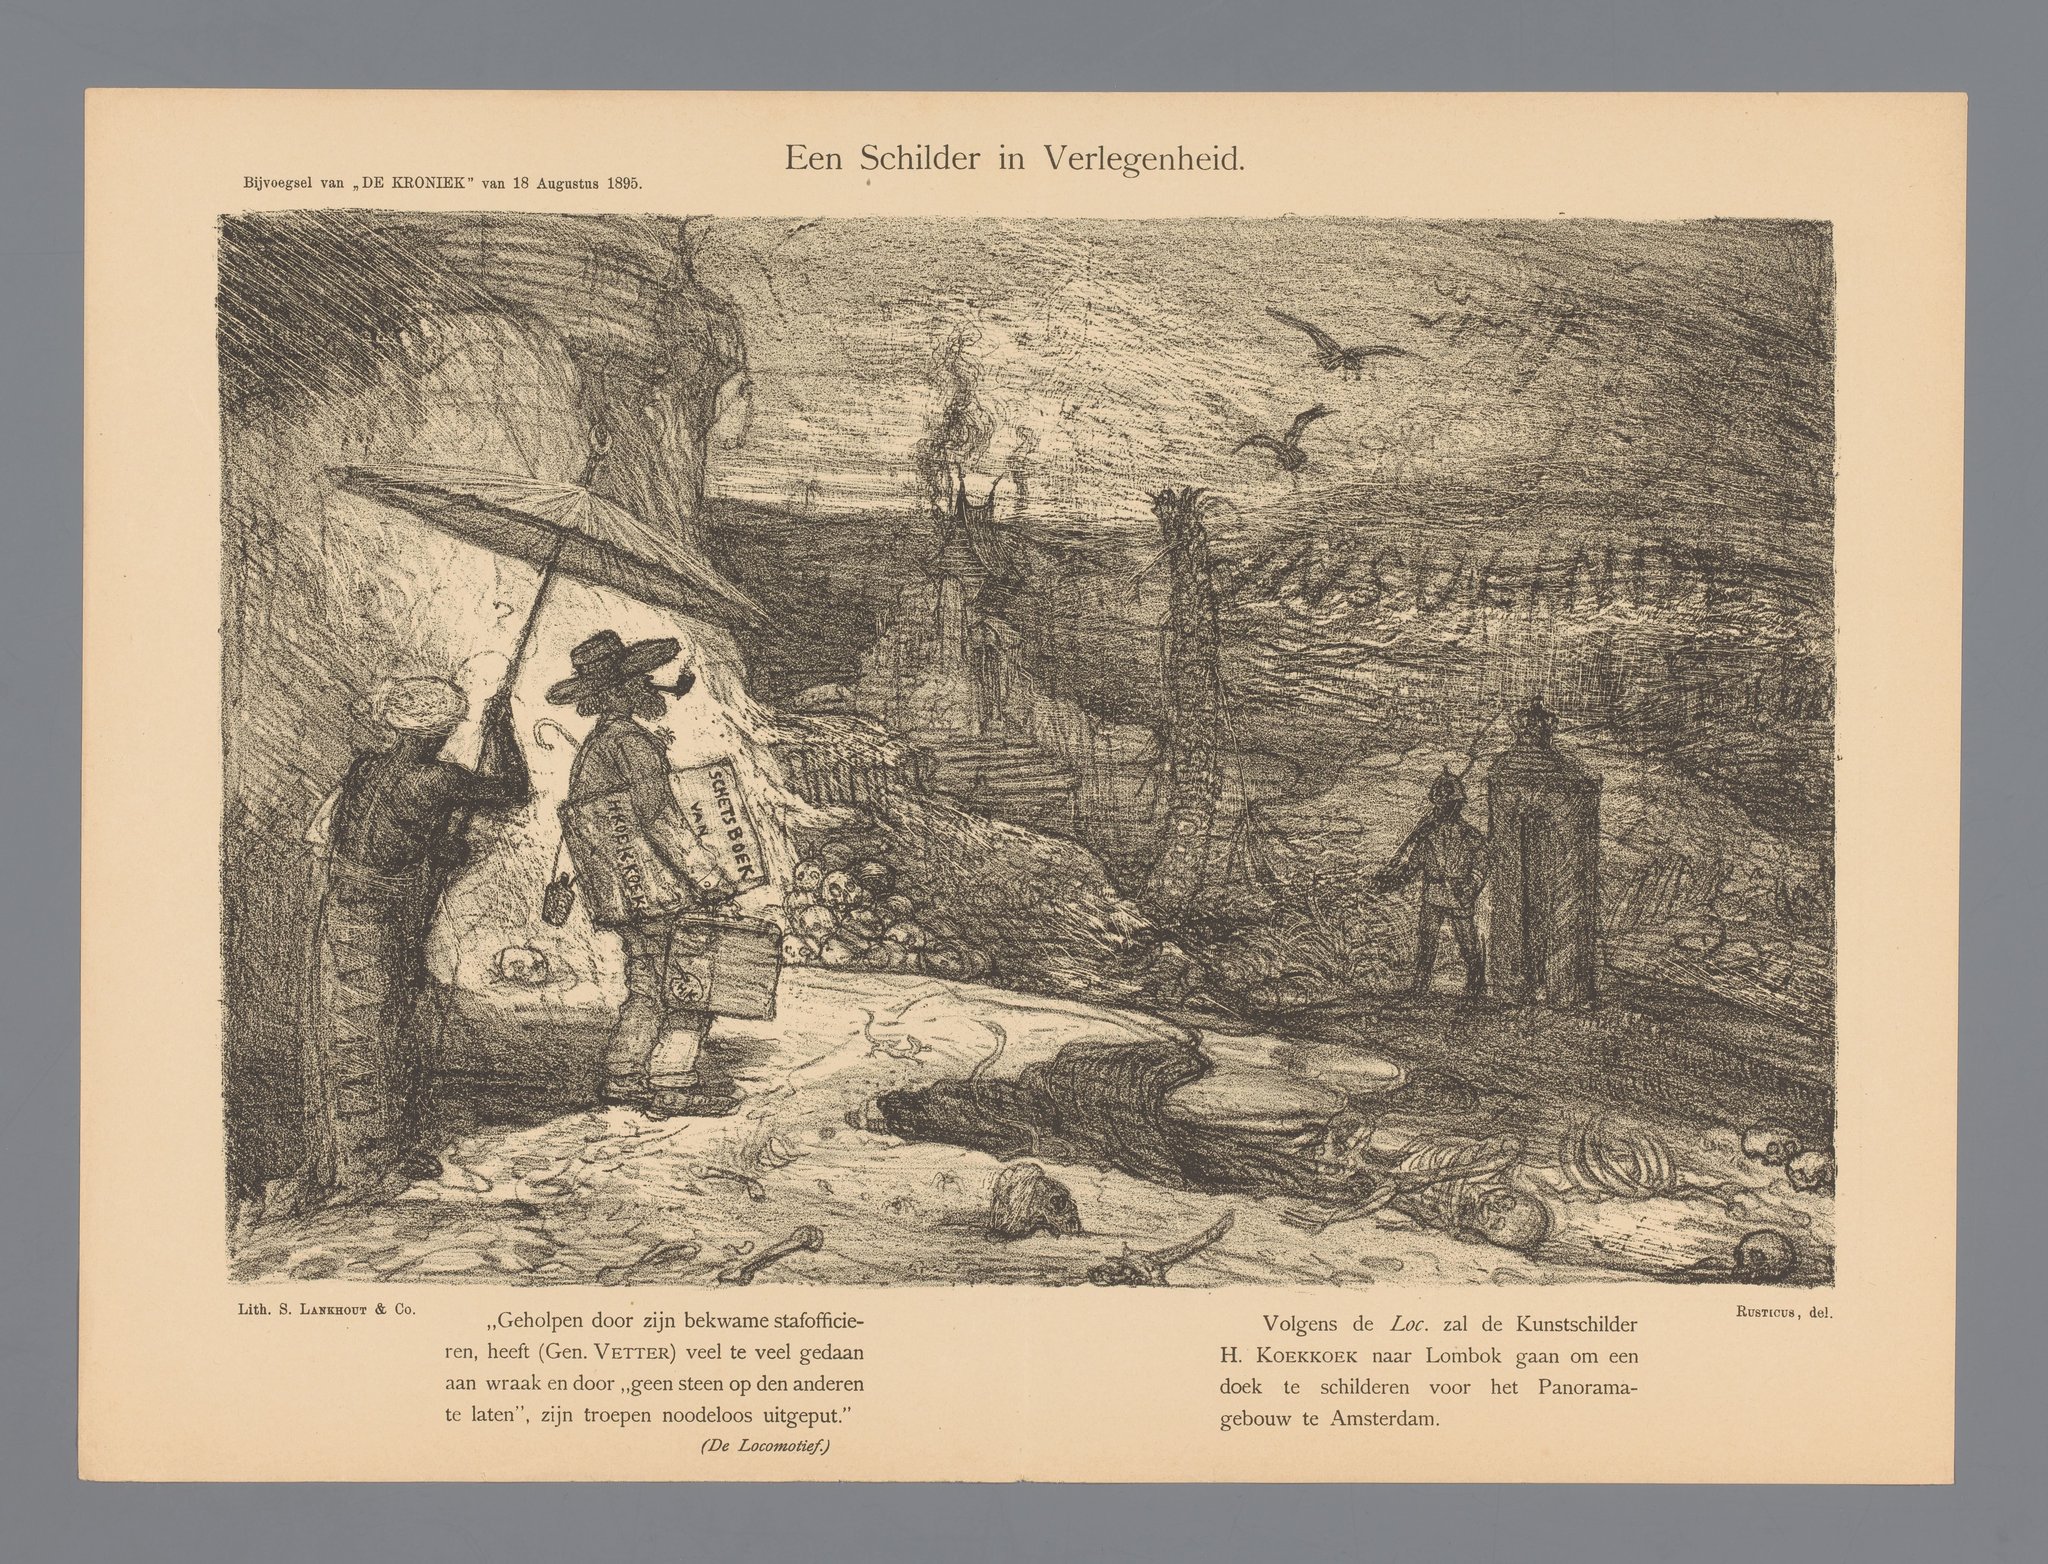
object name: print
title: Een Schilder in Verlegenheid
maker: marius bauer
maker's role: draughtsman, print maker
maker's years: 1867-1932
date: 1895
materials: paper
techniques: lithograph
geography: the hague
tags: amsterdam, london, painter, the hague, landscapes, historical persons, painter at work, in his studio - cc - out of doors, political caricatures and satires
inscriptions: date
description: De schilder Hermanus Koekkoek met zijn schetsboek gearriveerd bij de grens van het verwoeste 'Insulinde', hier verwijzend naar Lombok. Achter hem houdt een Lombokse man een parasol boven zijn hoofd. Kaal landschap bezaaid met skeletten en rokende puinhopen, aasgieren in de lucht, bewaakt door een soldaat staande bij zijn wachthuisje. Aanklacht tegen het bloedig optreden van Vetter bij het neerslaan van de opstand op Lombok in 1894. Onderaan twee teksten van vier regels.